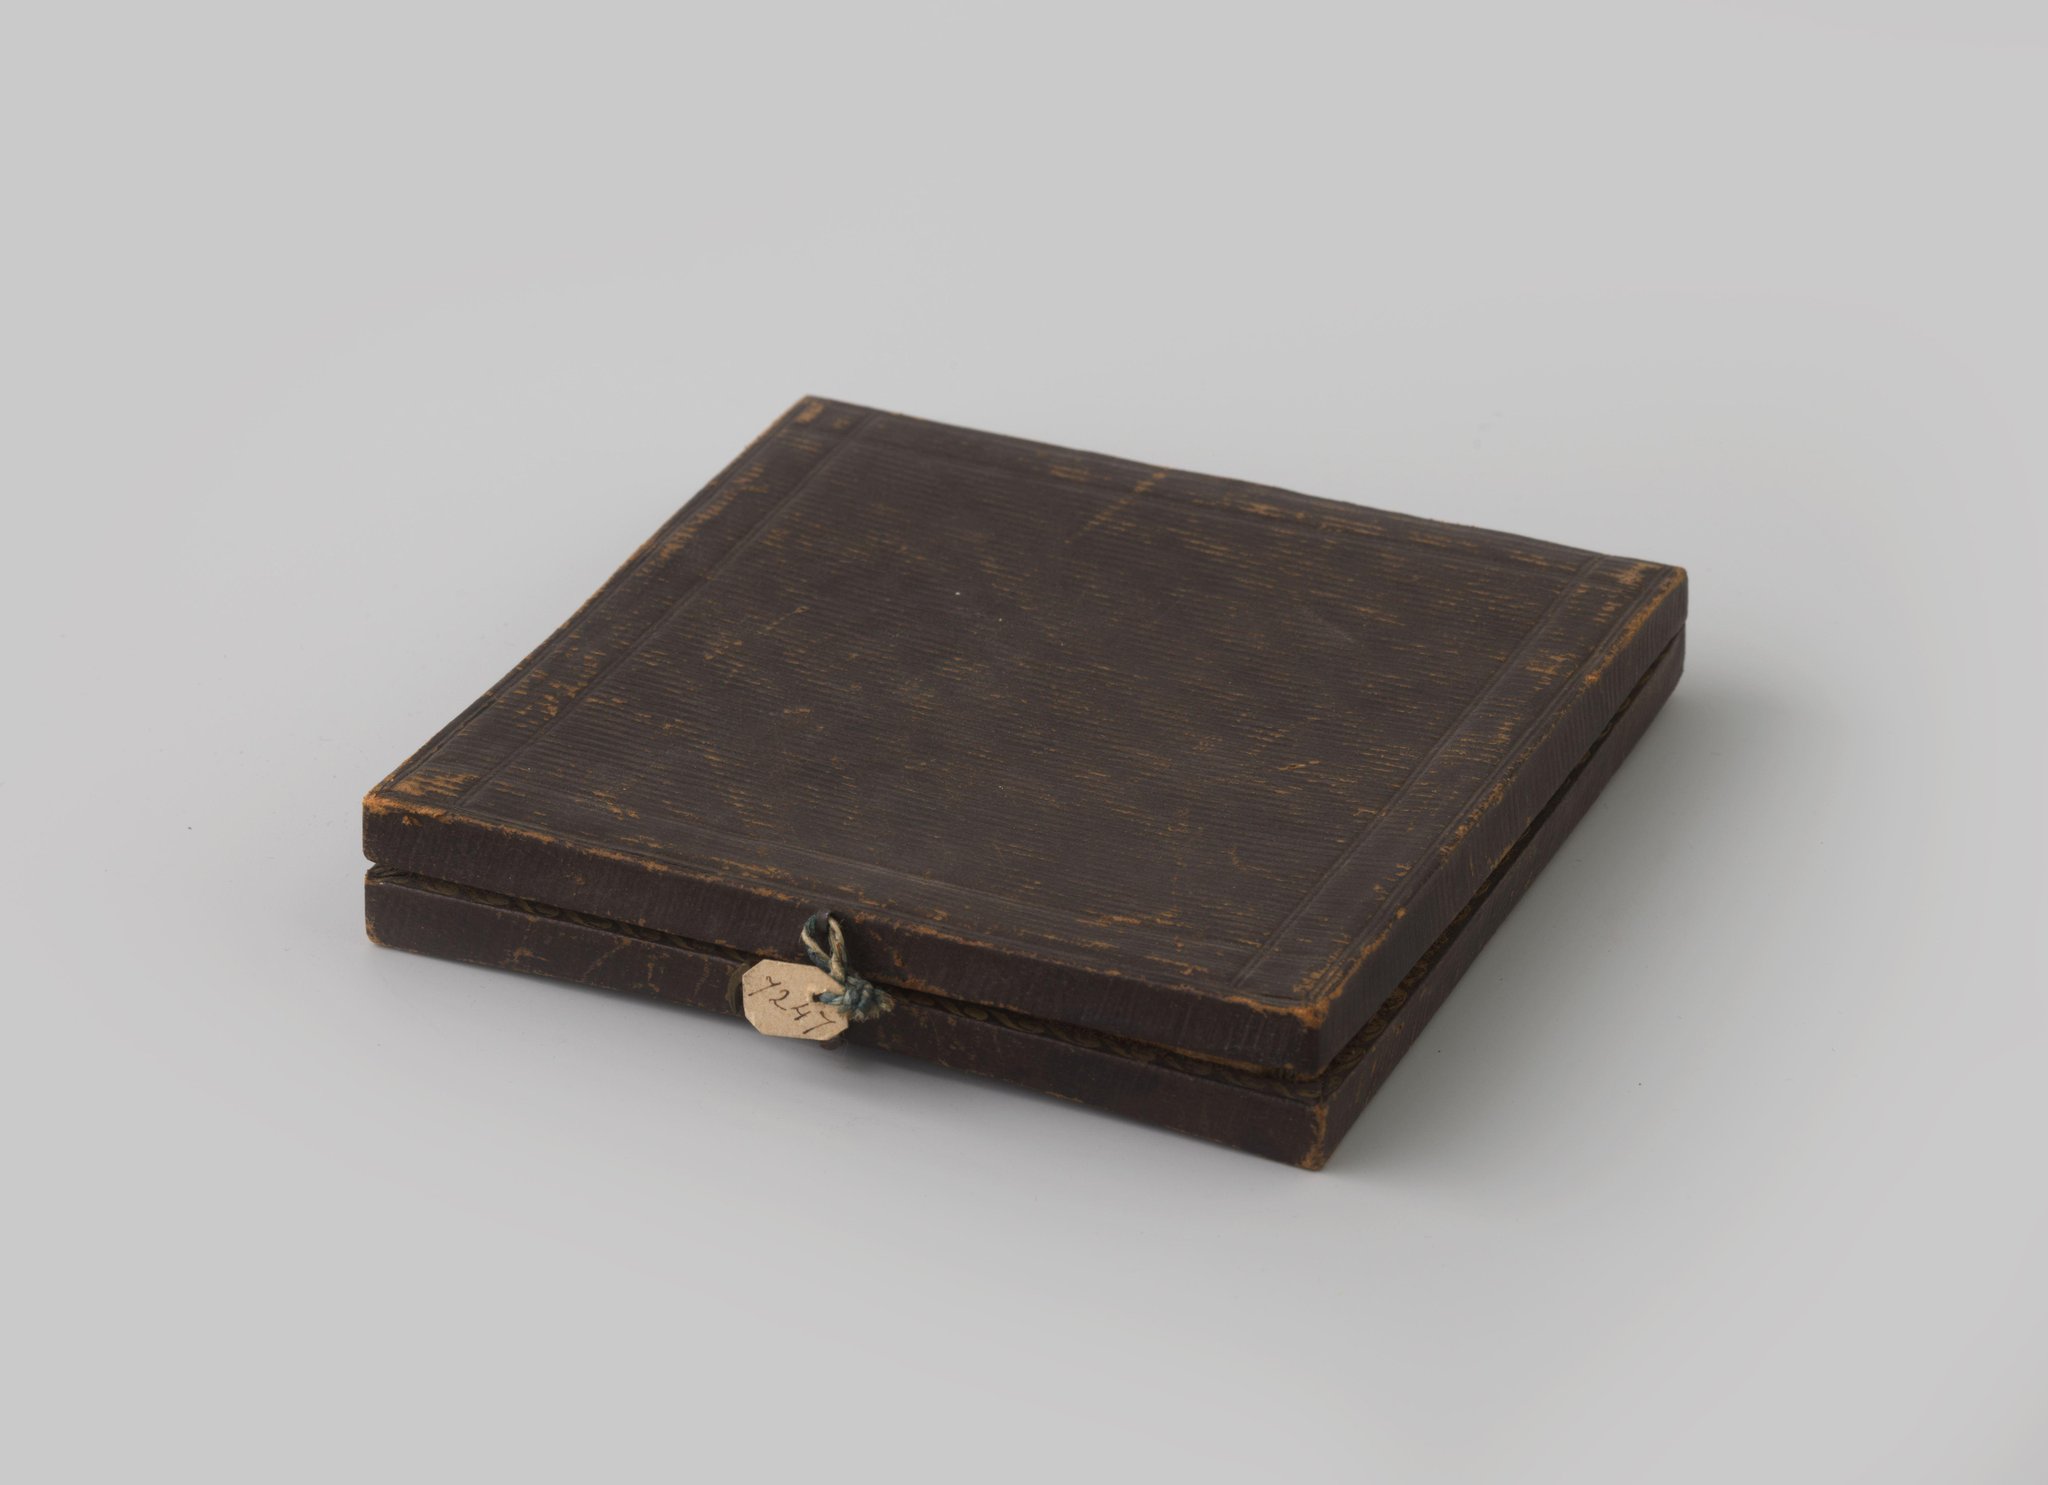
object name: étui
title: Foedraal voor een koperplaat met het symbool van de evangelist Johannes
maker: Anonymous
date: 1800-1900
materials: leather, wood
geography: netherlands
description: Vierkante bruine platte doos van hout. De binnenzijde is bekleed met zeemleer. Het is een foedraal gemaakt voor een koperplaat met het symbool van de evangelist Johannes.